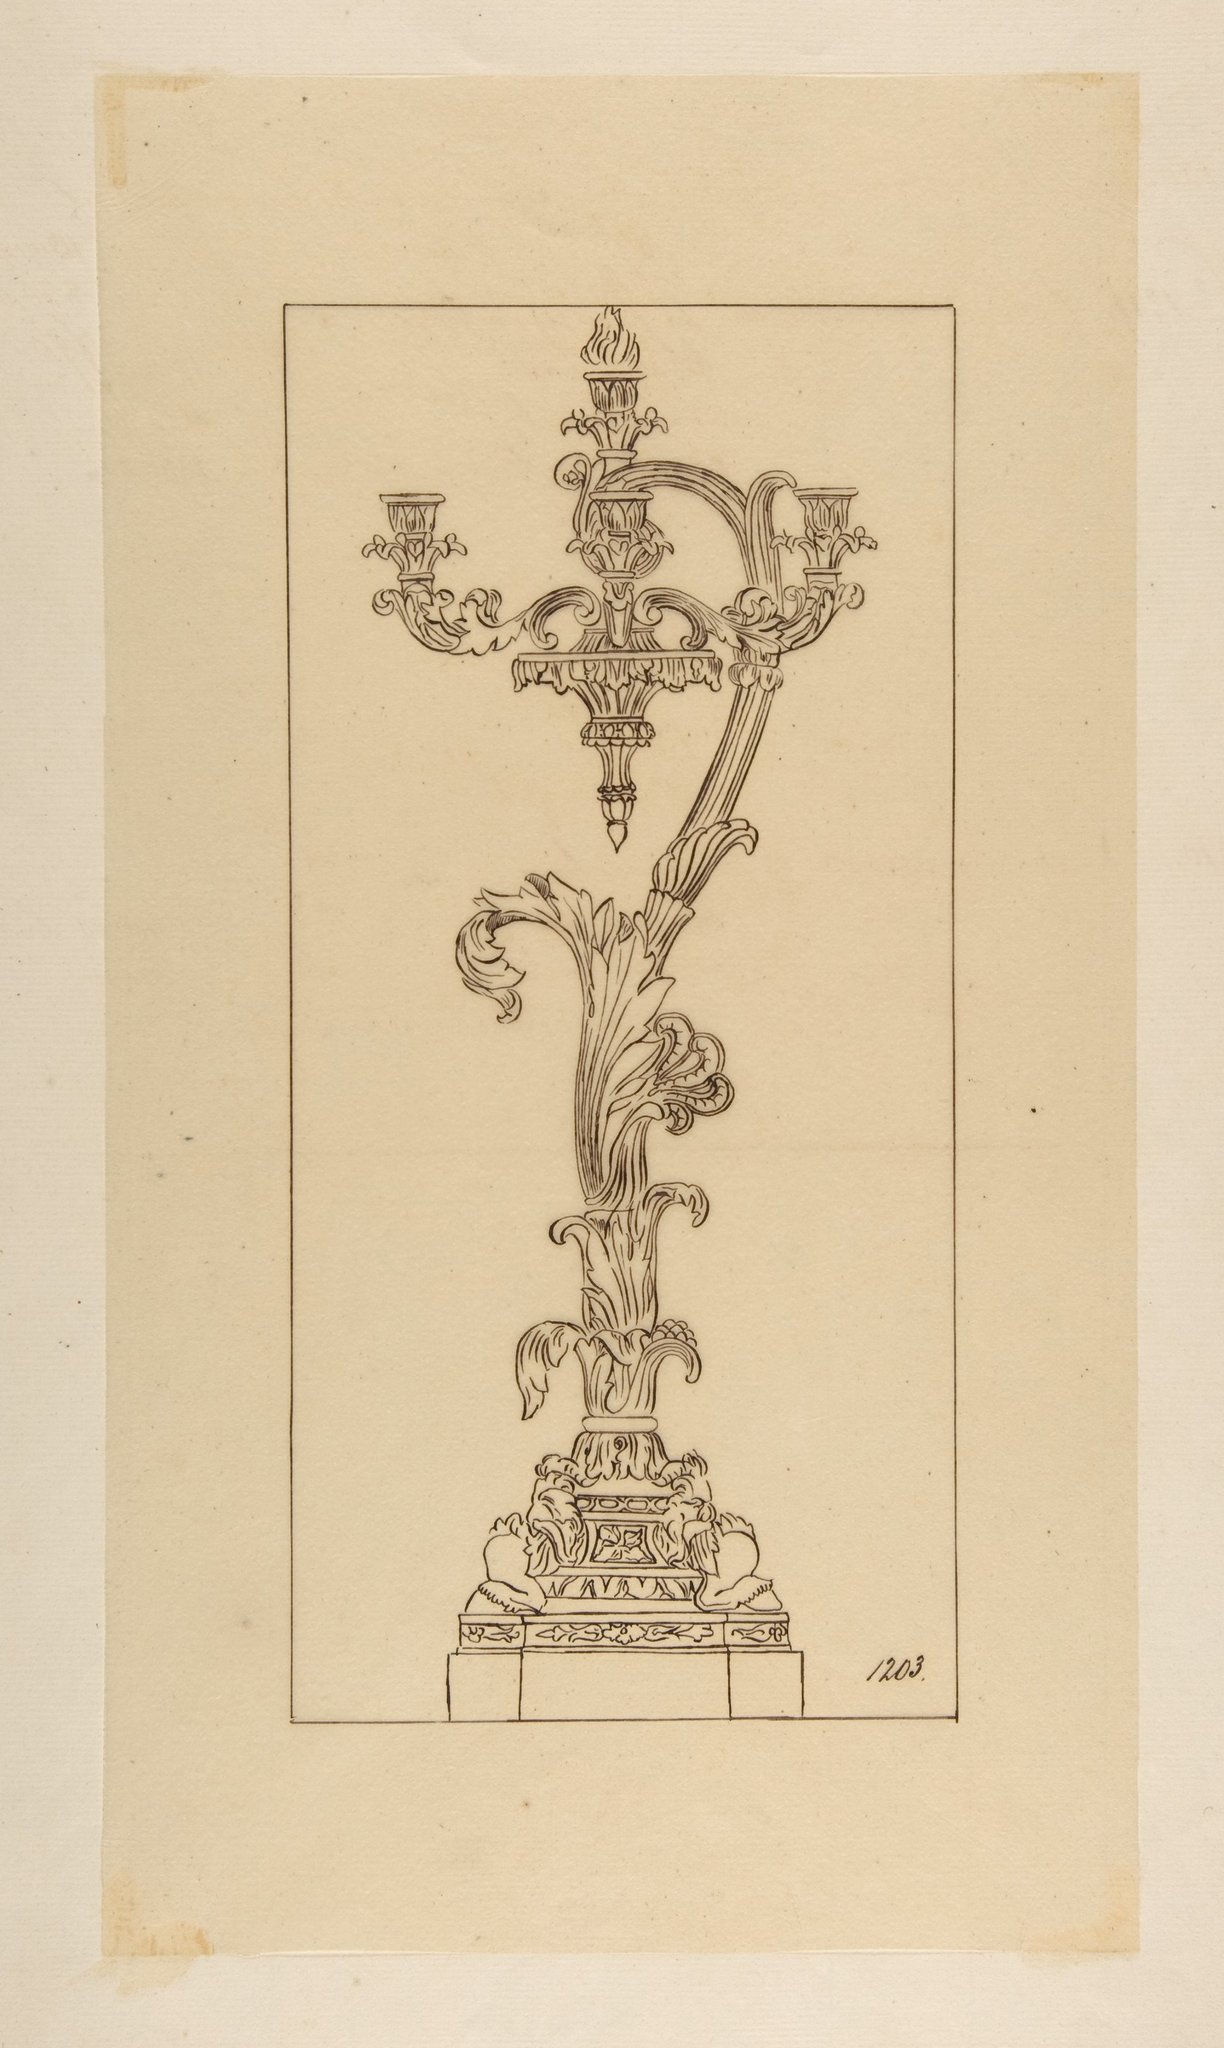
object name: drawing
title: Design for a Candelabra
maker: anonymous, french, 19th century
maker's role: artist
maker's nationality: french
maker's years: 1800-1900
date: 1801-1900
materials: ink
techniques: pen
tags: candelabra